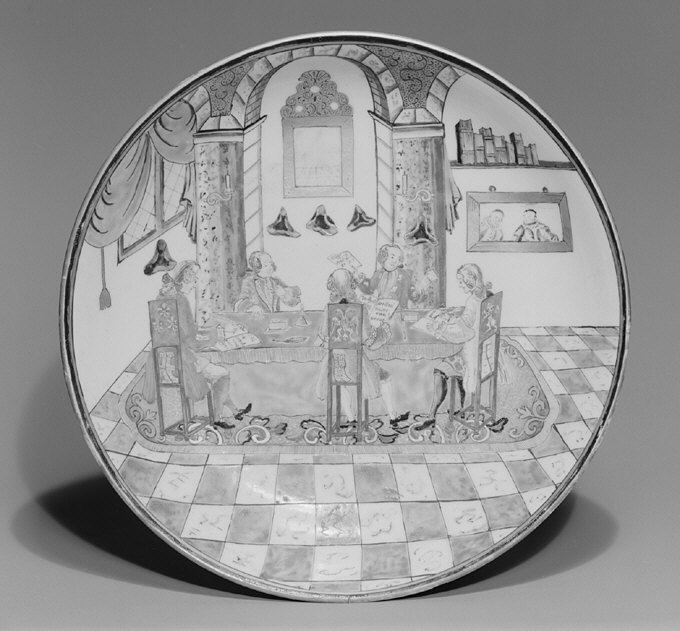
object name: plate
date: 1750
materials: hard paste porcelain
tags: human figures,reading